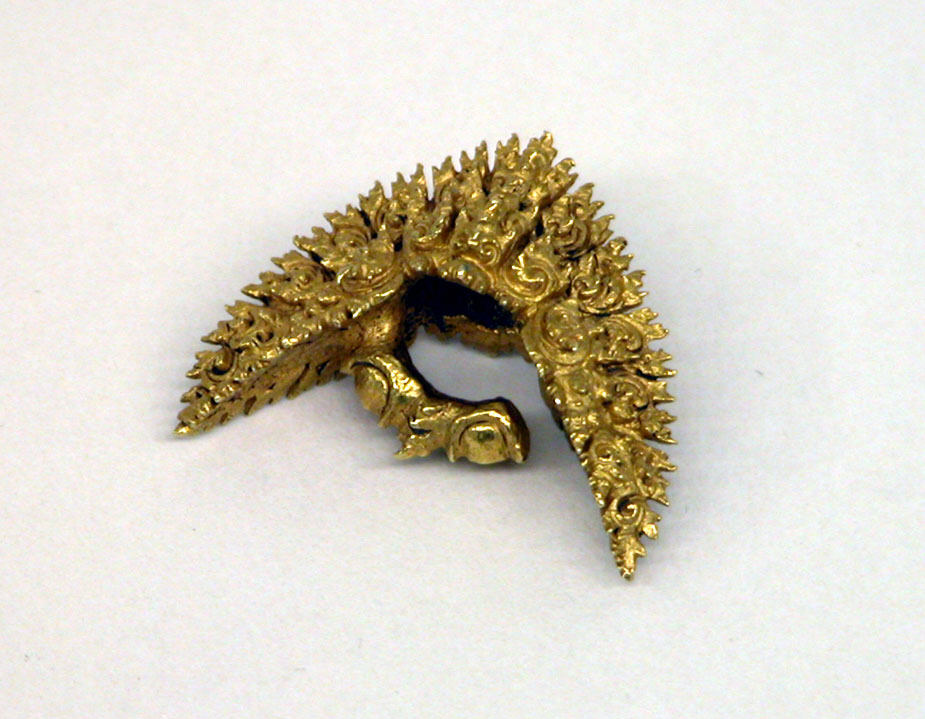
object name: ear ornament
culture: indonesian, javanese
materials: gold